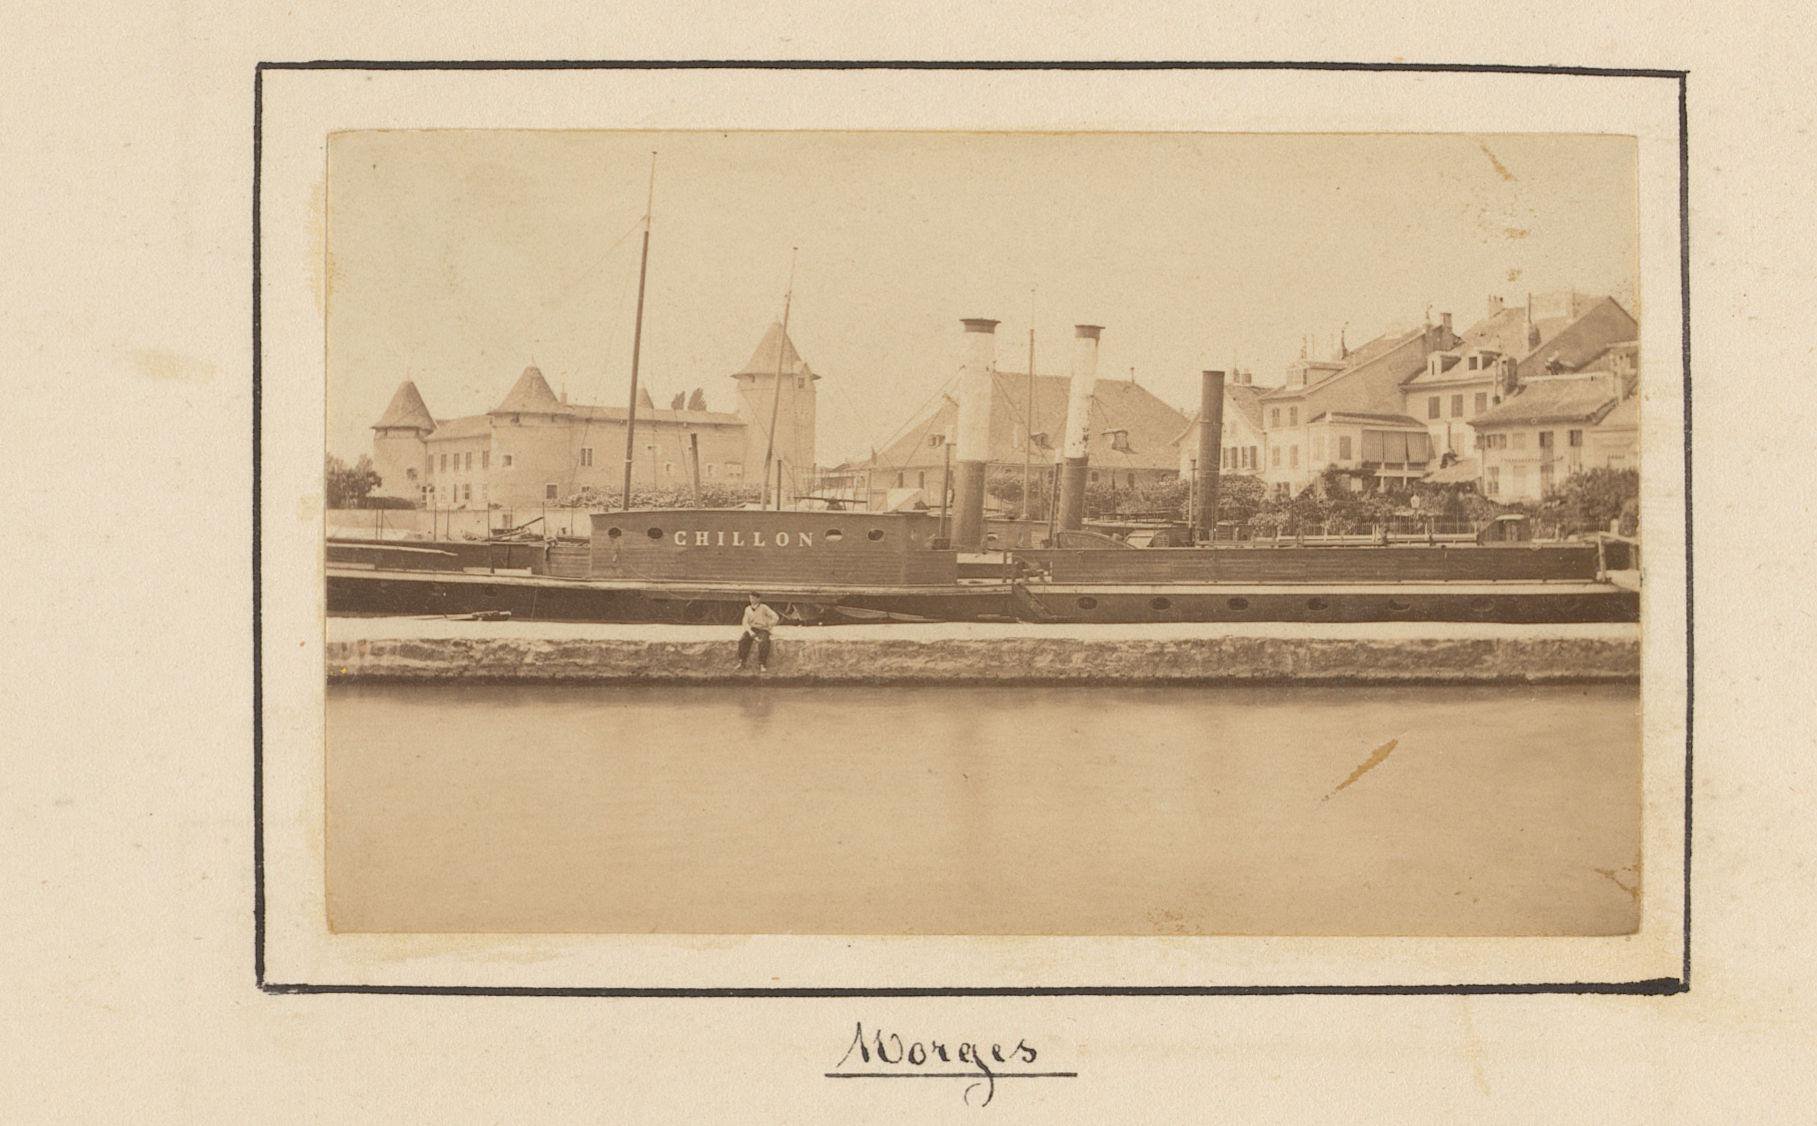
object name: photograph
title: Morges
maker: Anonymous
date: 1870-1890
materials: paper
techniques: albumen print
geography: morges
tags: lake, steamship, motorship